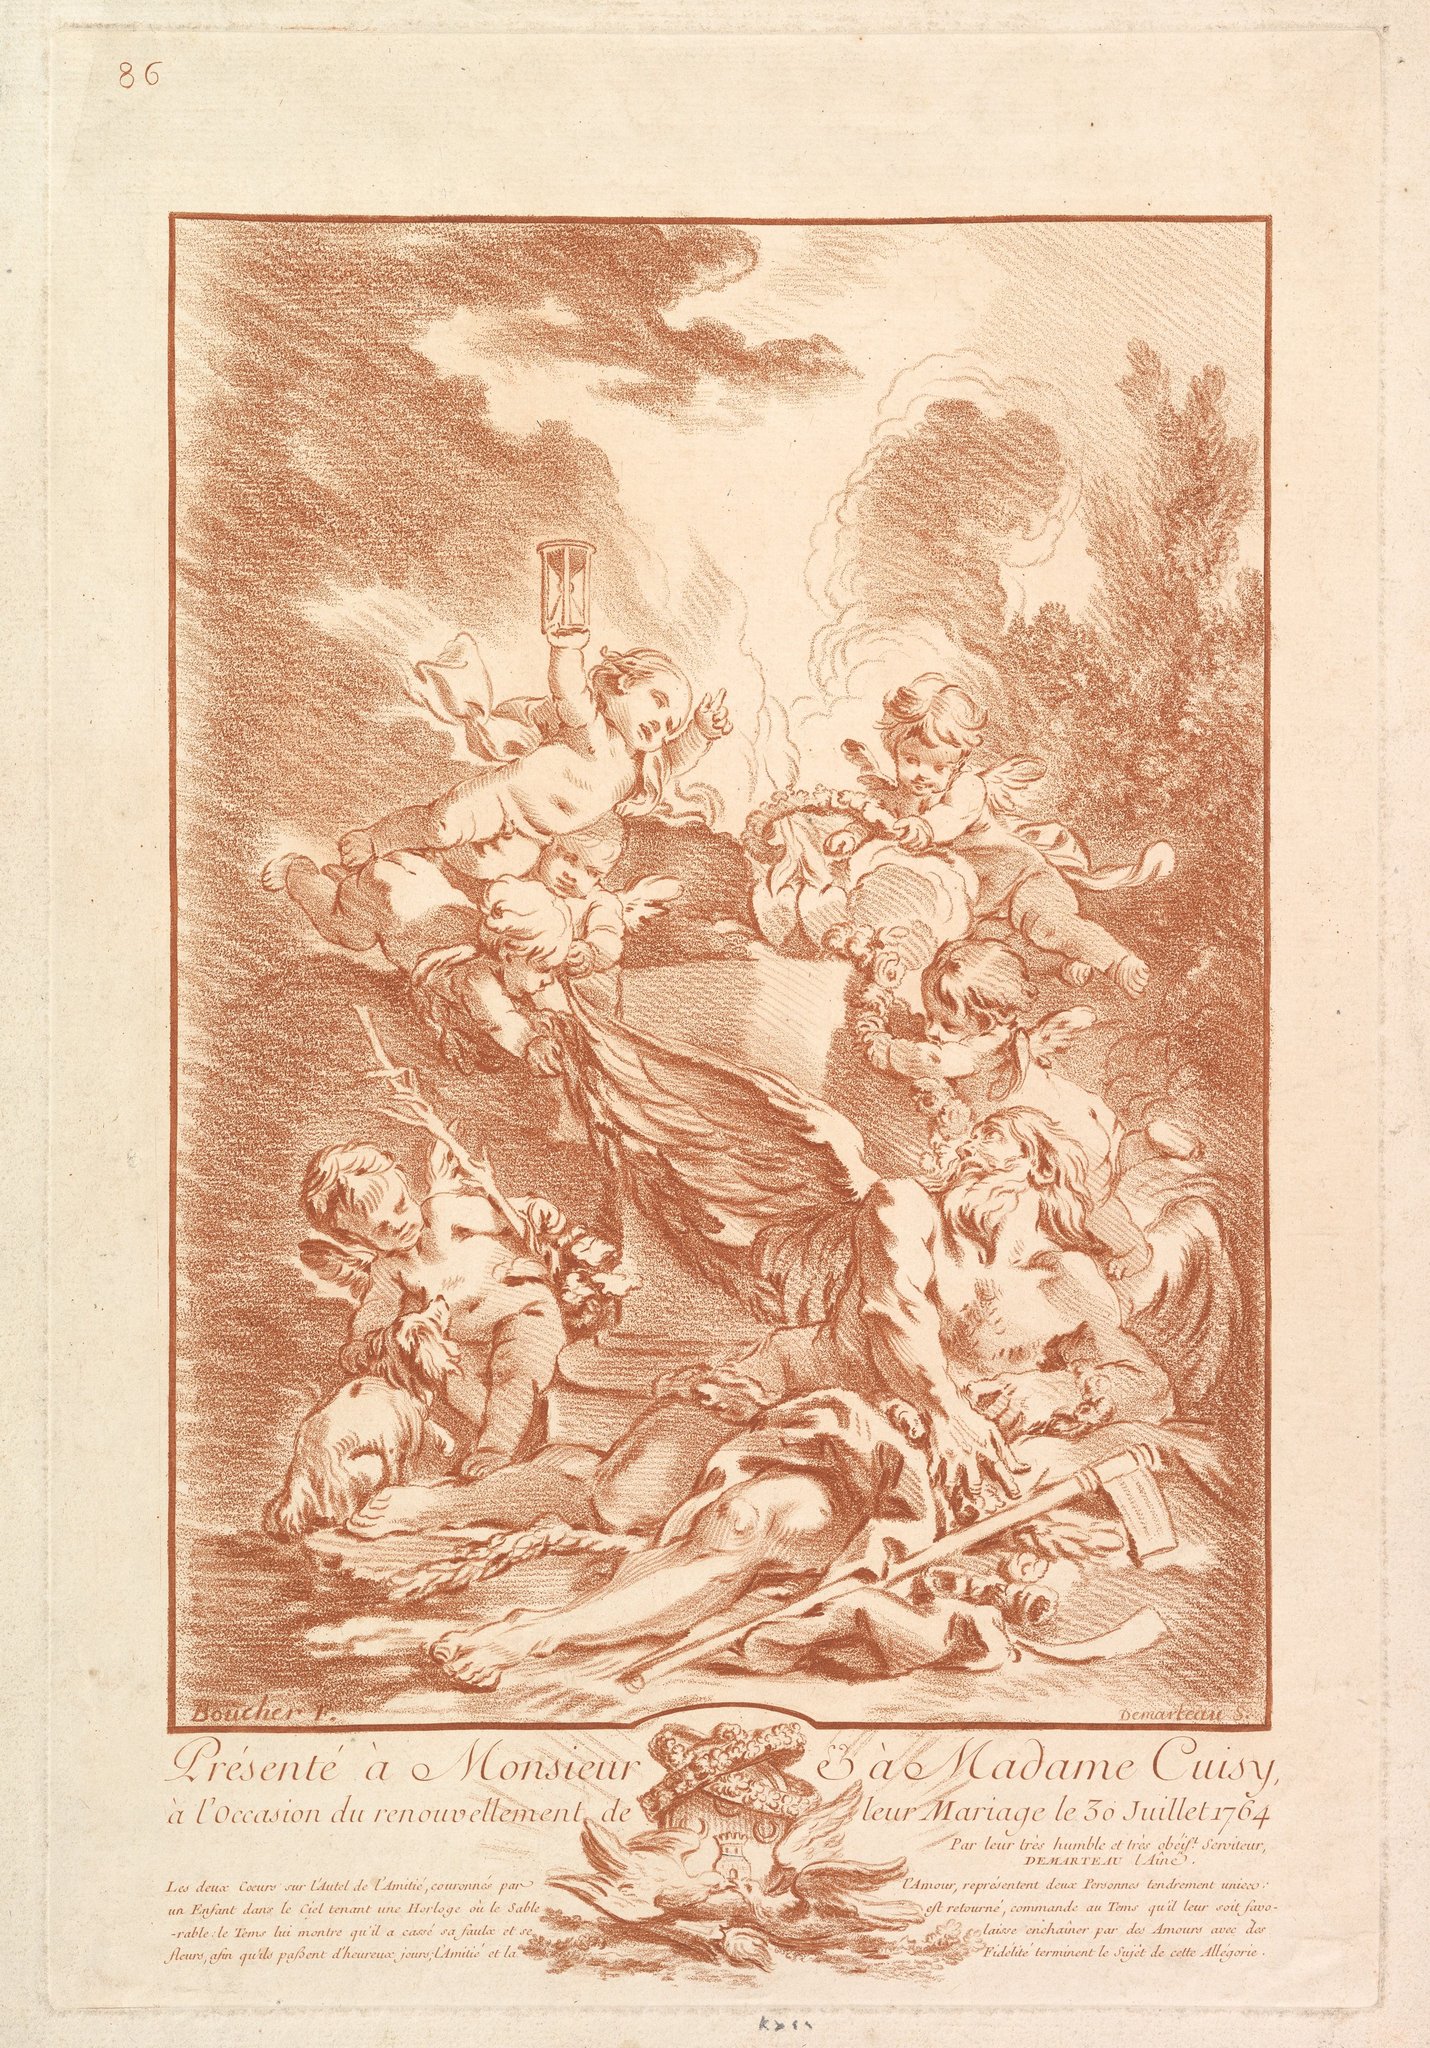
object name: print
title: Allégorie pour la Commémoration d'un Mariage (Allegory for the Commemoration of a Marriage)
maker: gilles demarteau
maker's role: artist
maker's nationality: french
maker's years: 1722-1776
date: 1734-1766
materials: ink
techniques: printmaking, engraving